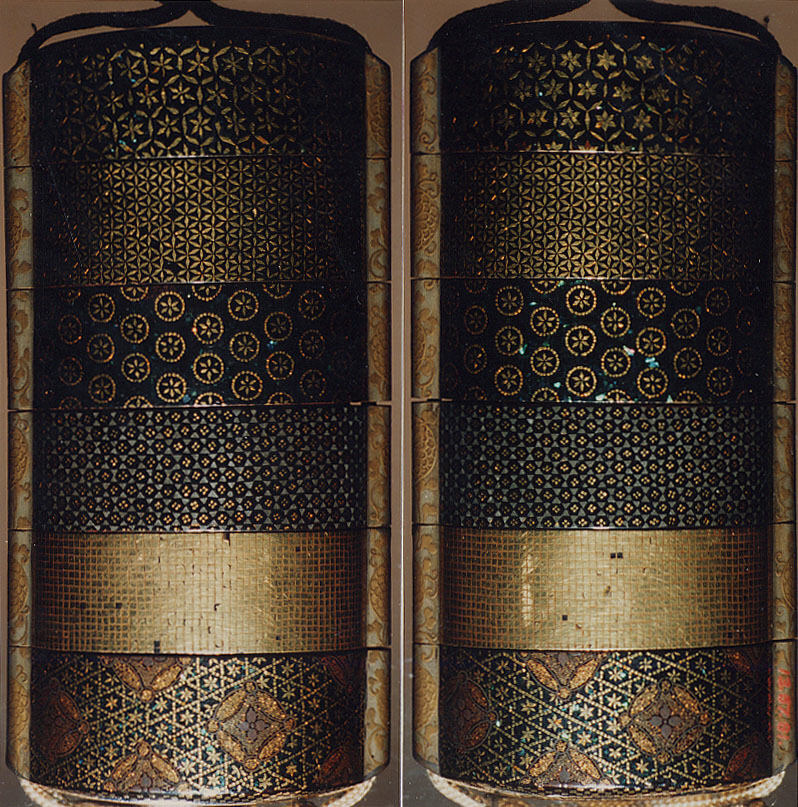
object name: inrō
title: Case (Inrō) with Design of Various Brocade Patterns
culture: japanese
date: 1801-1900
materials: gold foil, lacquer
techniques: fundame, roiro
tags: flowers